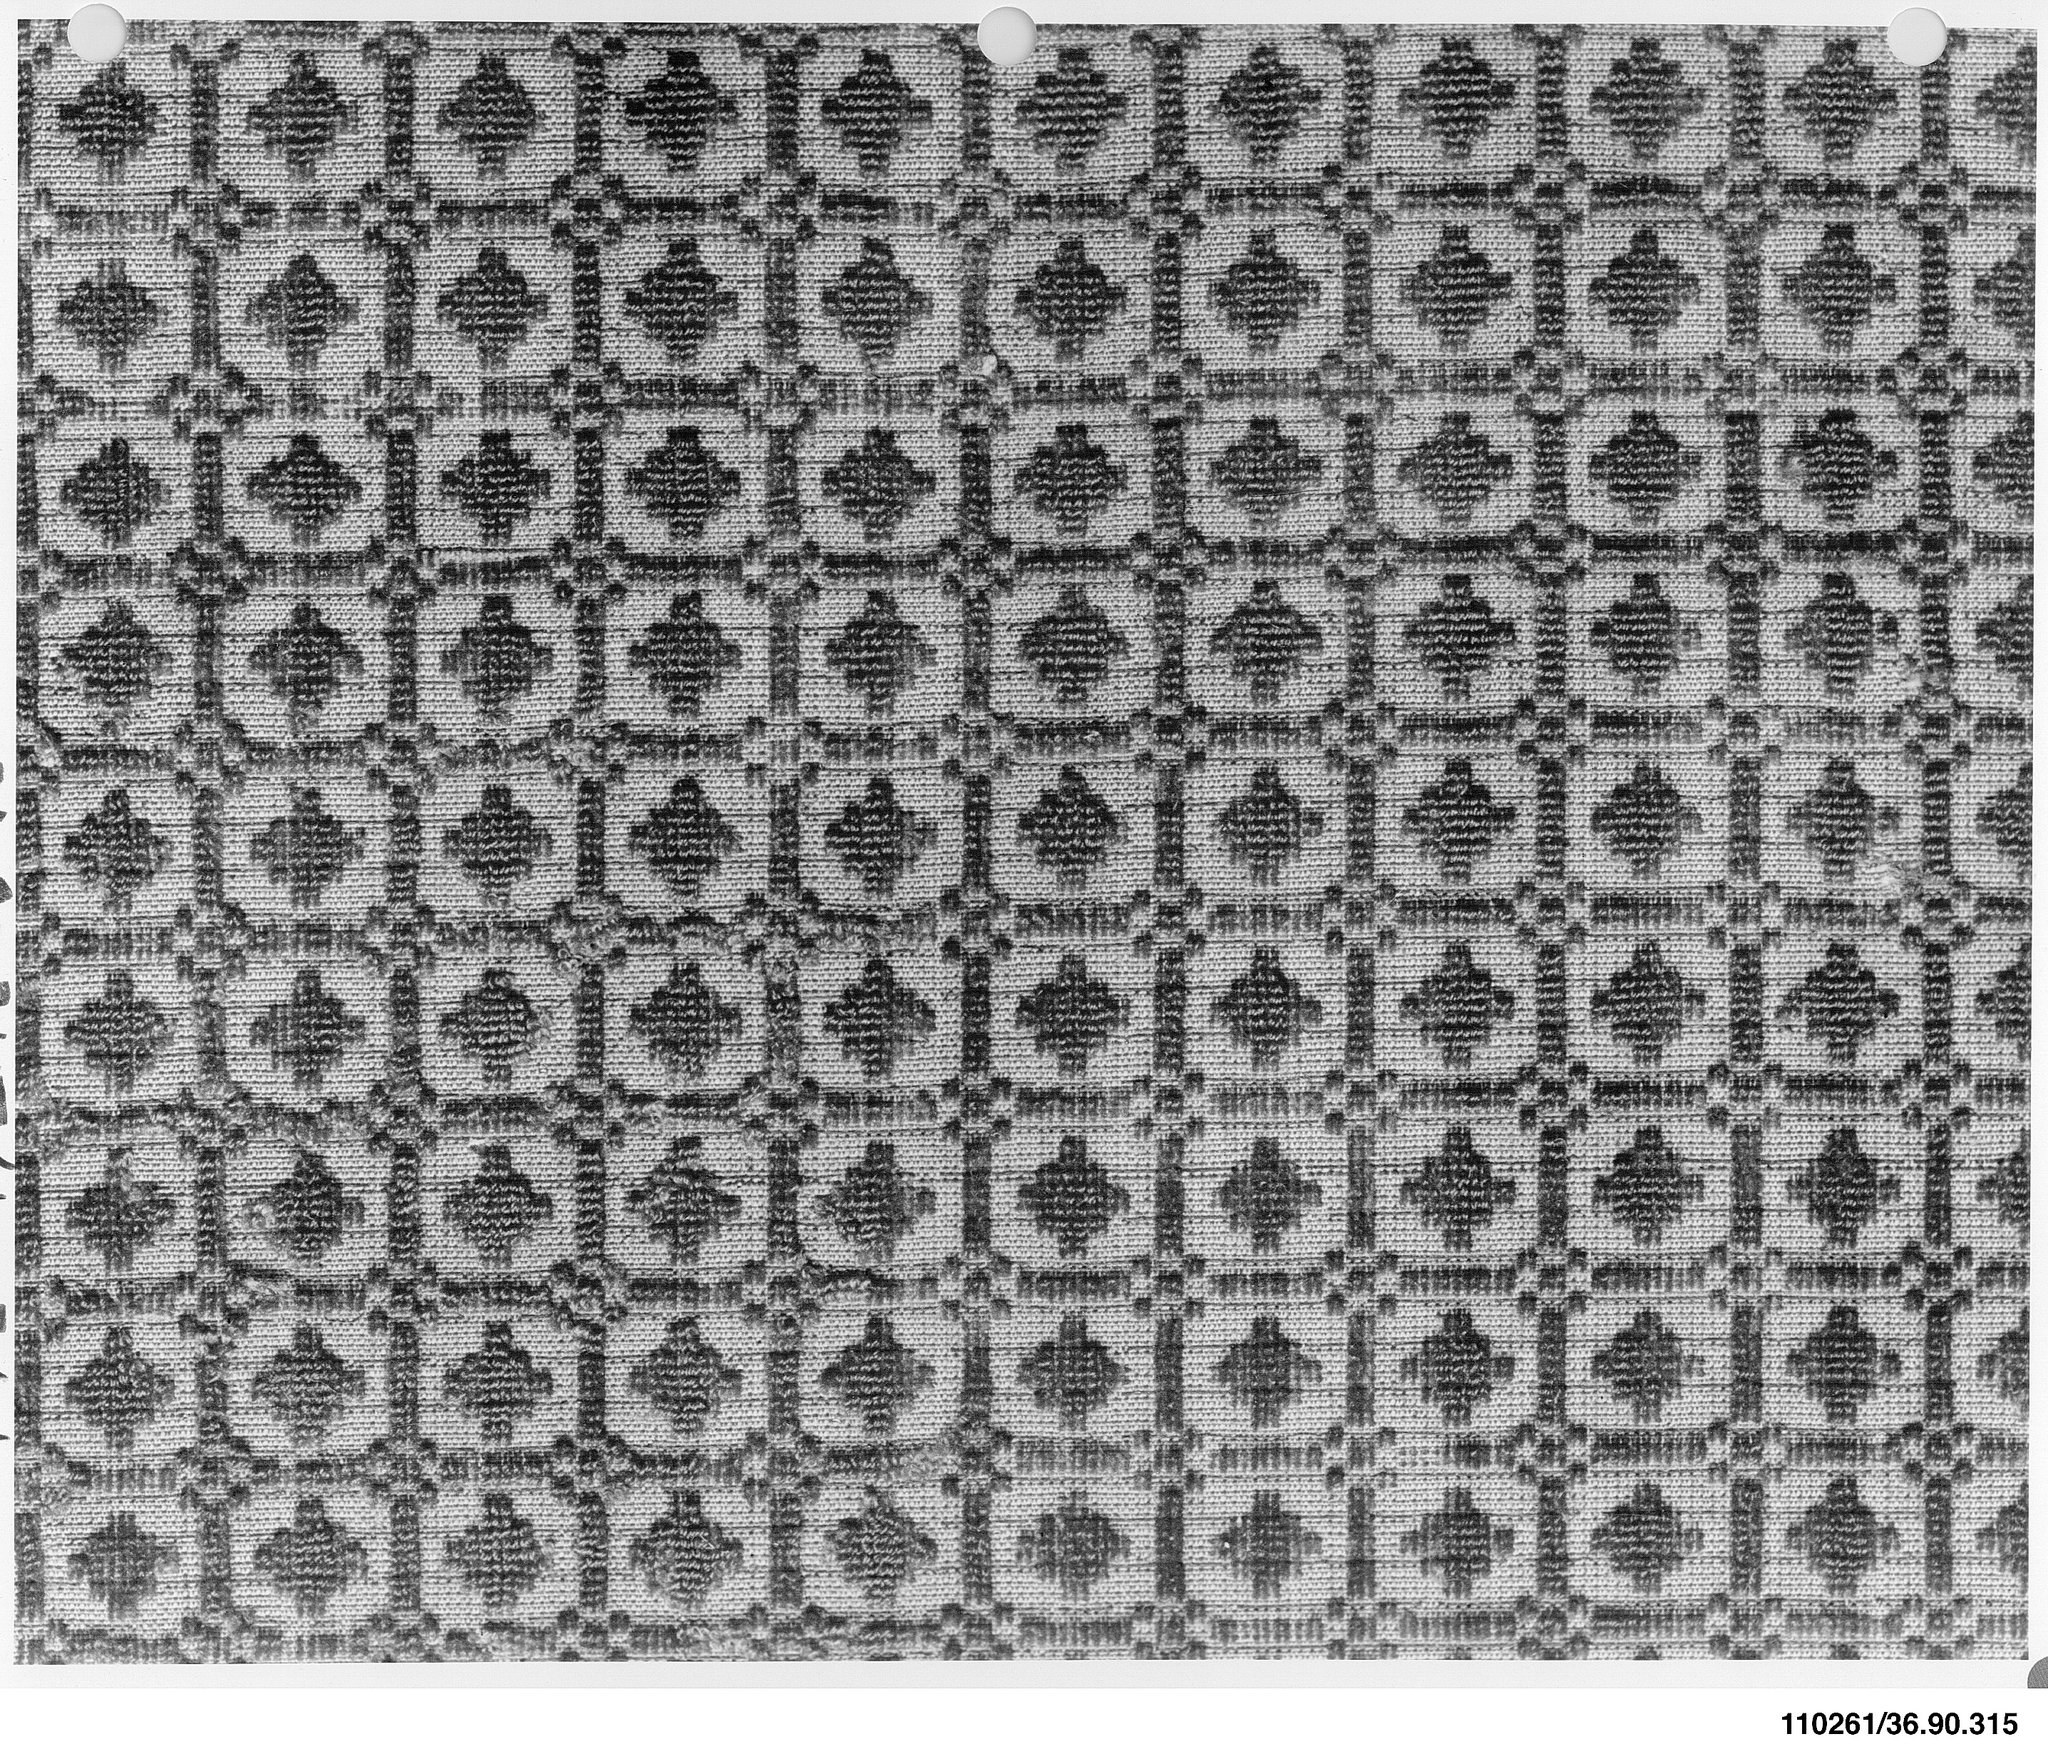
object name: piece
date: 1501-1700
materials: silk